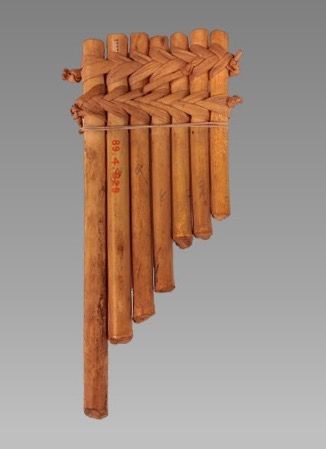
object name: bue balabala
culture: melanesian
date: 1867-1900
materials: bamboo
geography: vanuatu